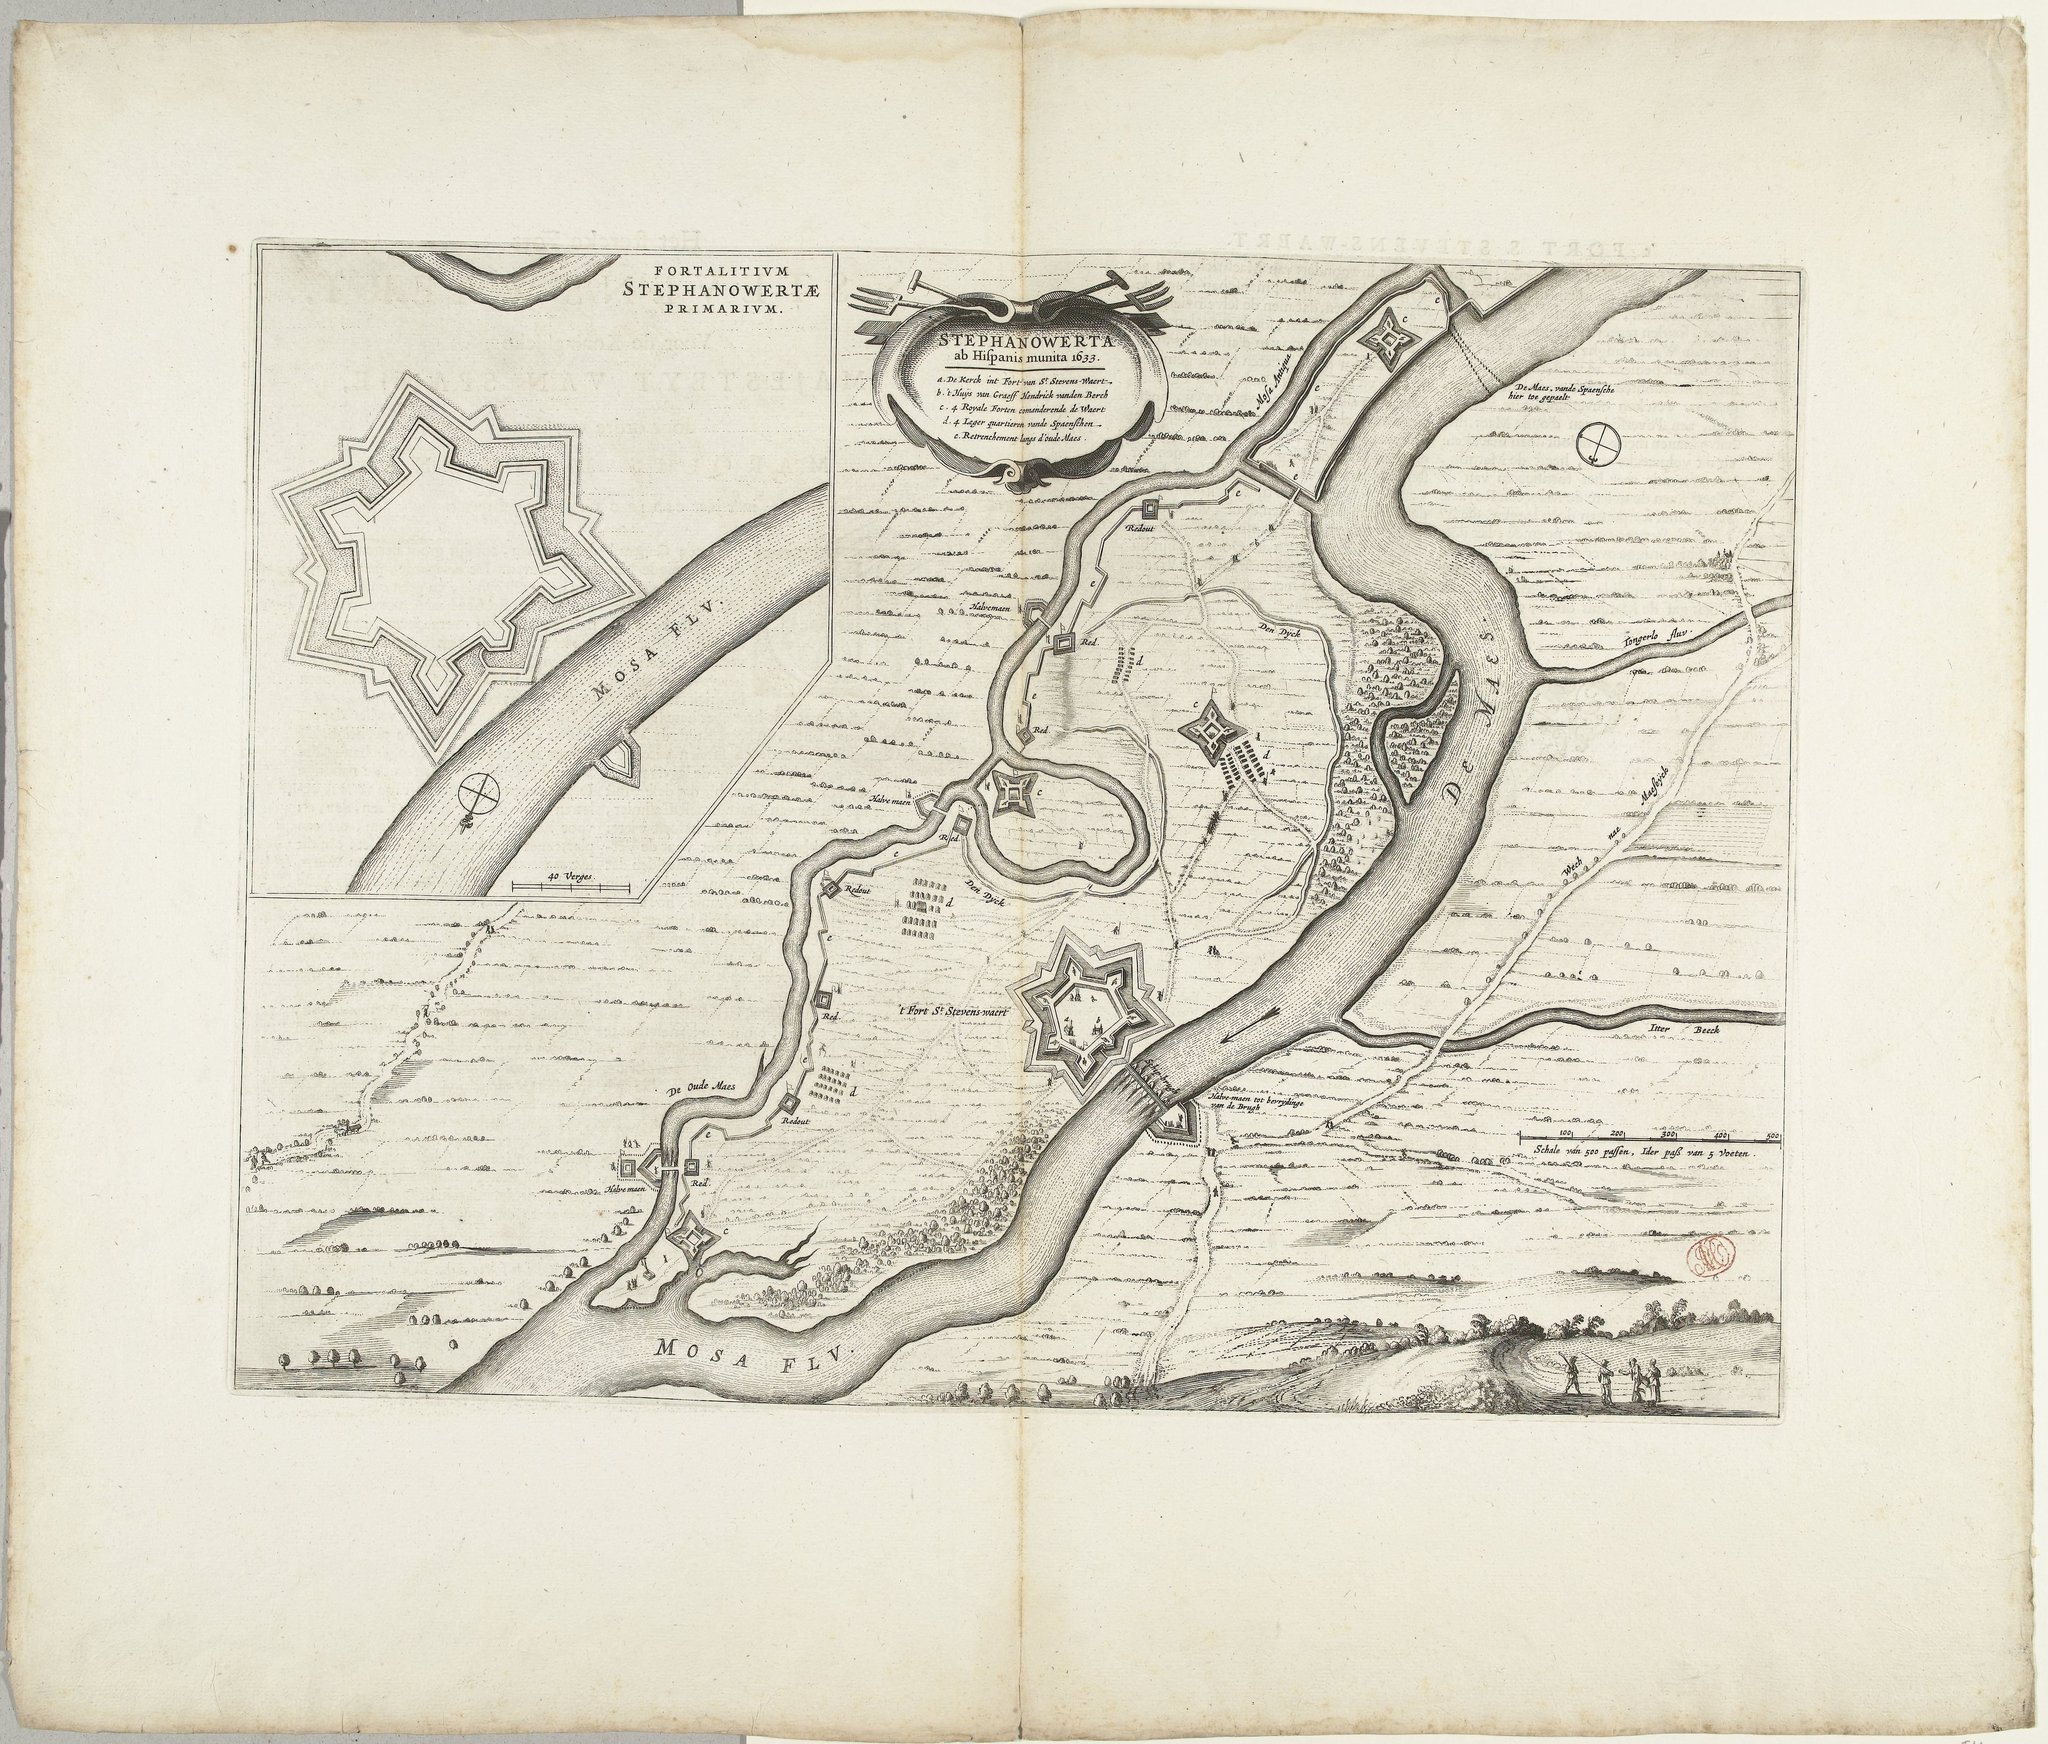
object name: history print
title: Het stercke Fort S. Stevens-waert, Voor de Koninglijcke Majesteyt van Spanje, door ordre van den Marquis d' Aytona, in 't jaer MDCXXXIII, gebouwt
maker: Anonymous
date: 1647-1649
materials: paper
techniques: etching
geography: northern netherlands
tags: brussels, francisco de moncada (markies van aytona), maps of separate countries or regions, fortifications, military engineering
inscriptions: collector's mark: Lugt 195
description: Kaart met de versterkingen in het gebied rond Stevensweert aangelegd door de Spanjaarden onder de markies van Aytona, juli 1633. Linksboven een inzet met een detailkaart van de versterkingen om Stevensweert. Op de voorgrond rechts enkele wandelaars op een weg. Op een dubbelblad genomen uit het Stedenboek van Blaeu. Bedrukt op achterzijde met tekst in het Nederlands.